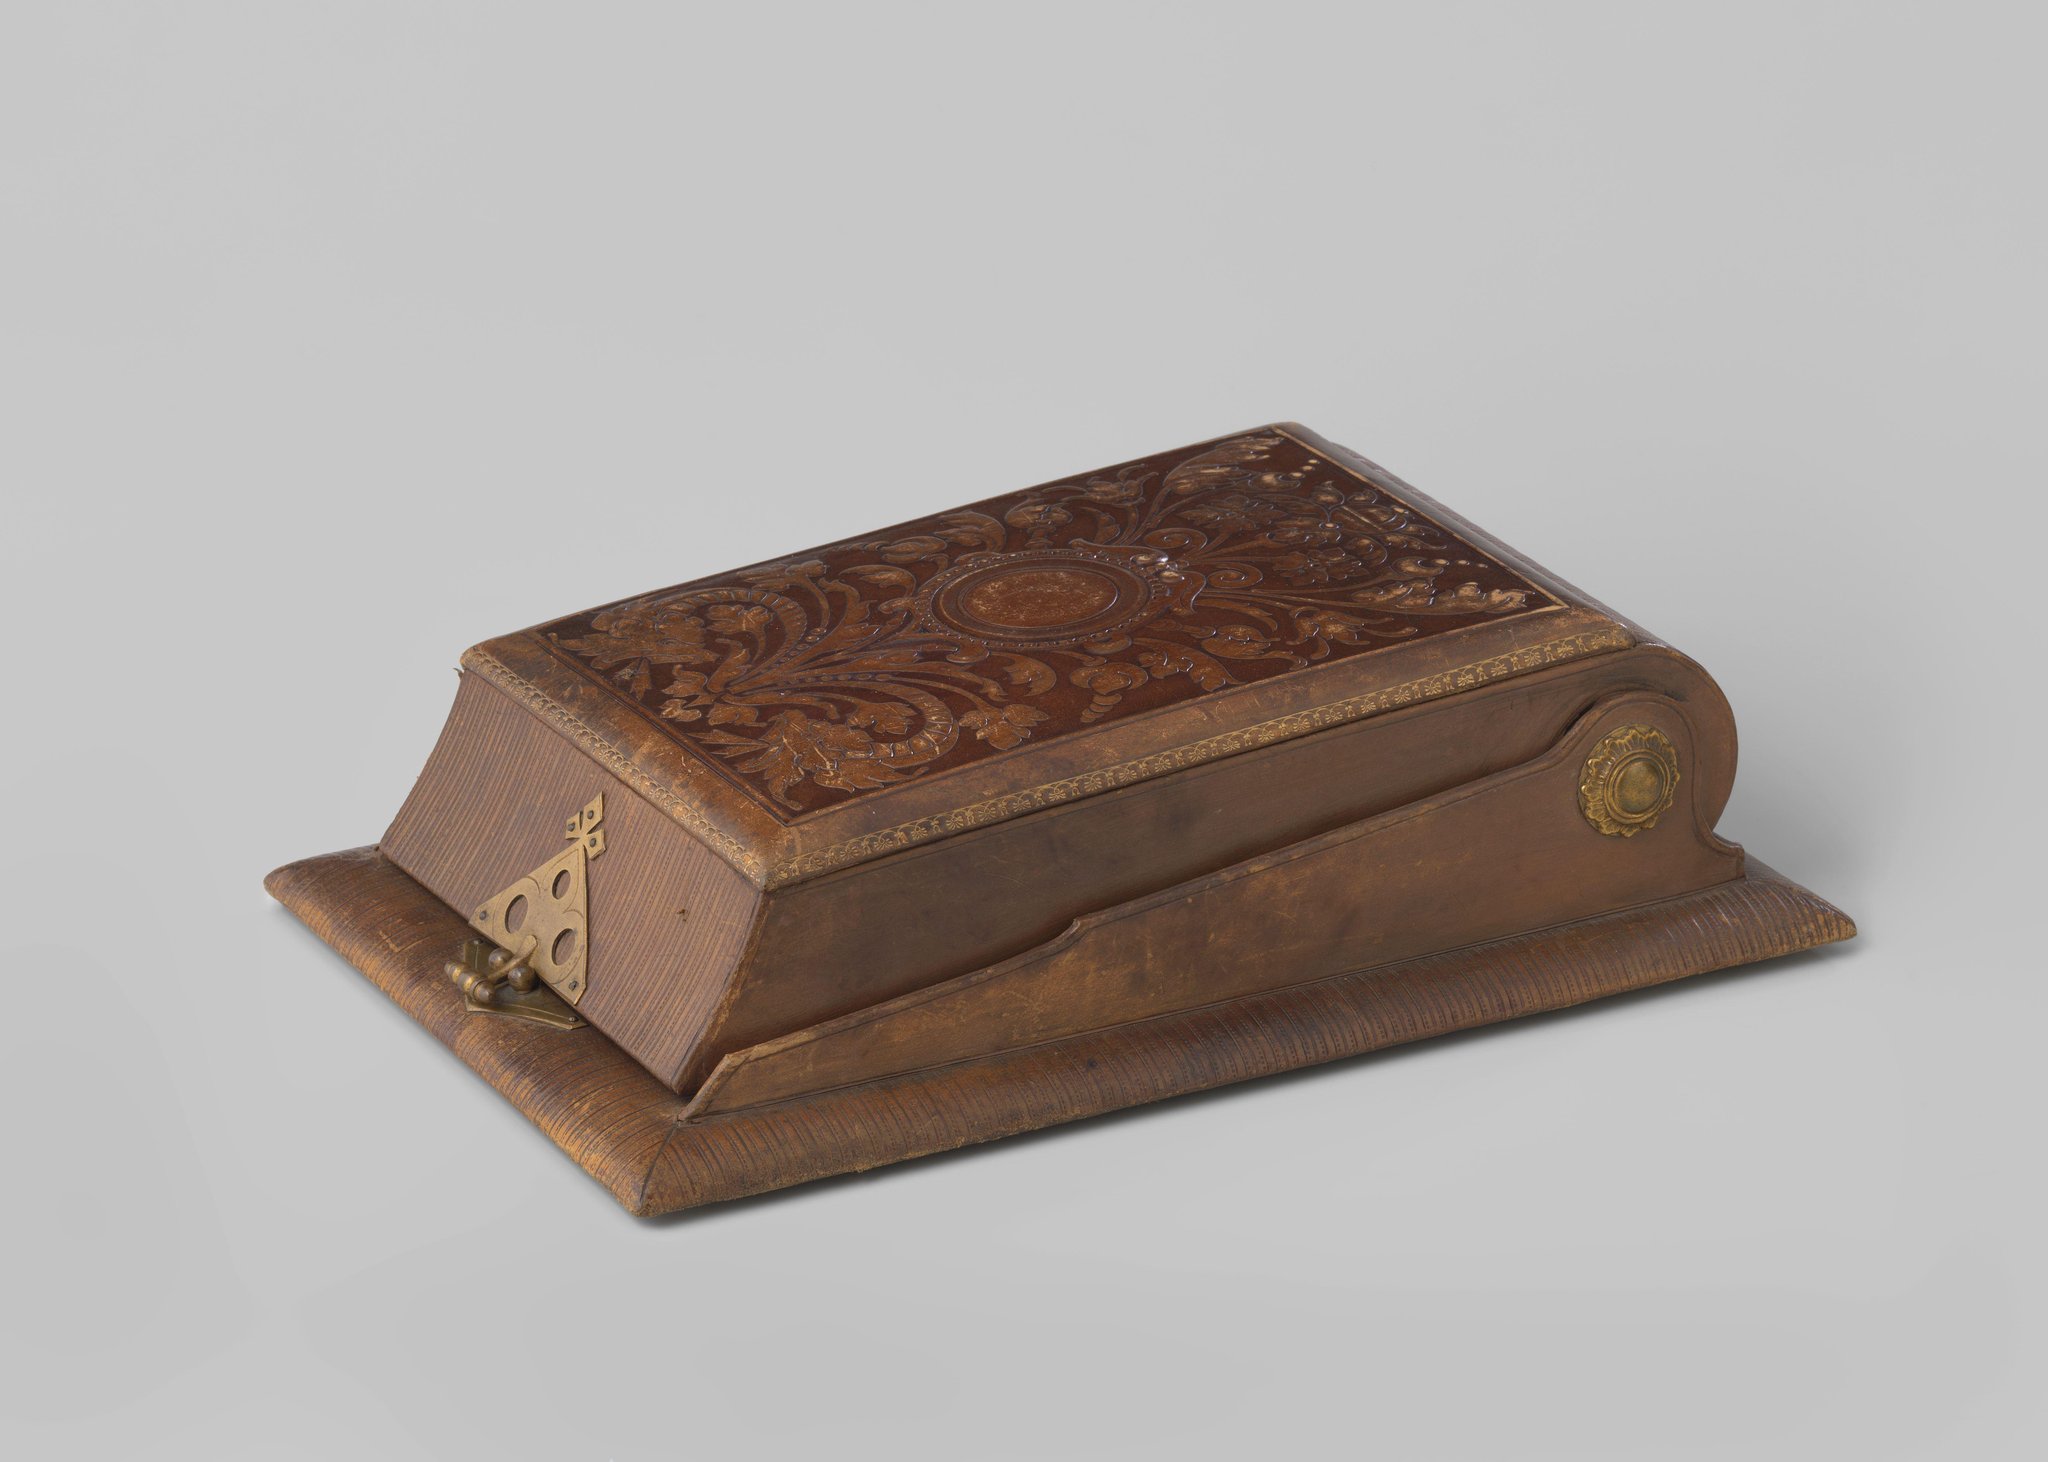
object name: slip in album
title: Familiealbum met 29 foto's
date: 1860-1917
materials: cardboard, leather, metal, photographic support, textile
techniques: albumen print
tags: historical persons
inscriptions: inscription: ‘Dienst Verspreide Rijkskollekties (...)’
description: Fotoalbum met 15 bladen met in totaal 29 kabinetfoto's. Het album bevat portretten van mannen, vrouwen en kinderen.